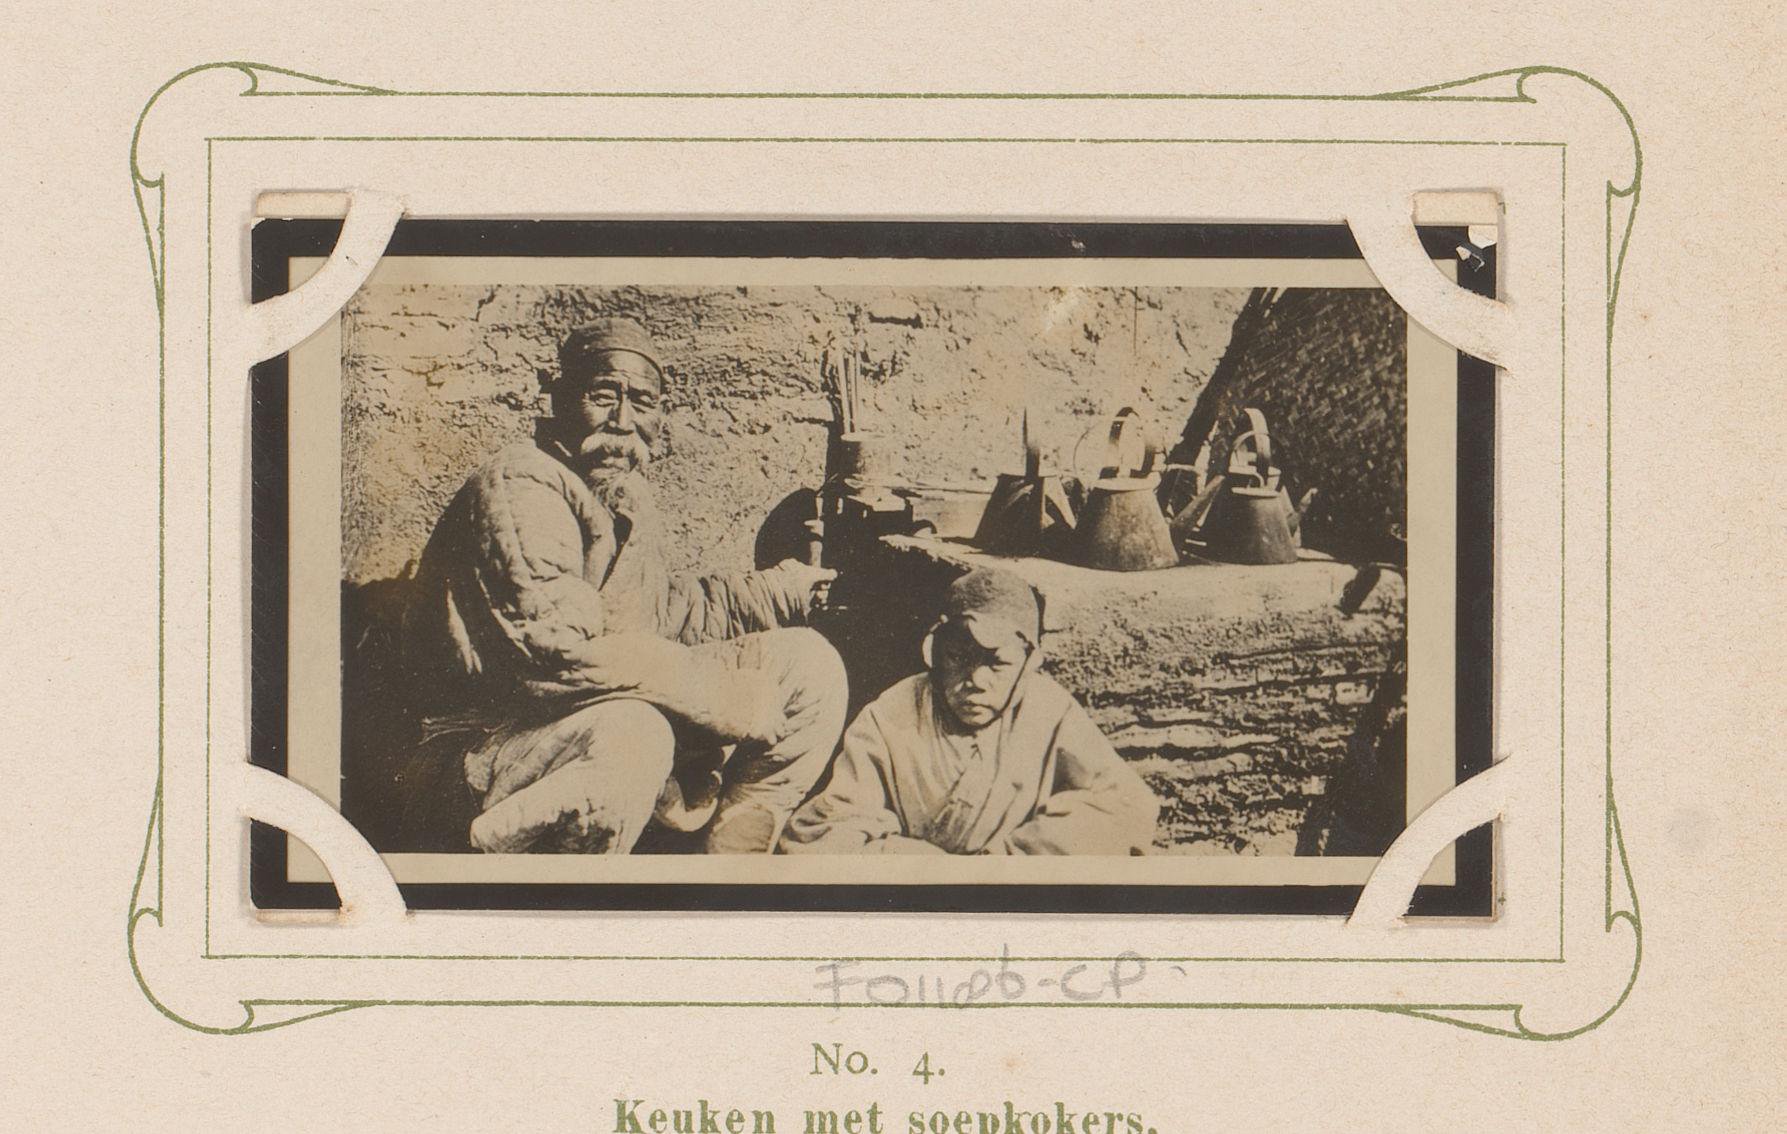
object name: album leaf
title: Twee mannen in een keuken te China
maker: Anonymous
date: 1904-1905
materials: photographic support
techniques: gelatin silver print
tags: kitchen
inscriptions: inscription: ‘No. 4./ Keuken met soepkokers.’